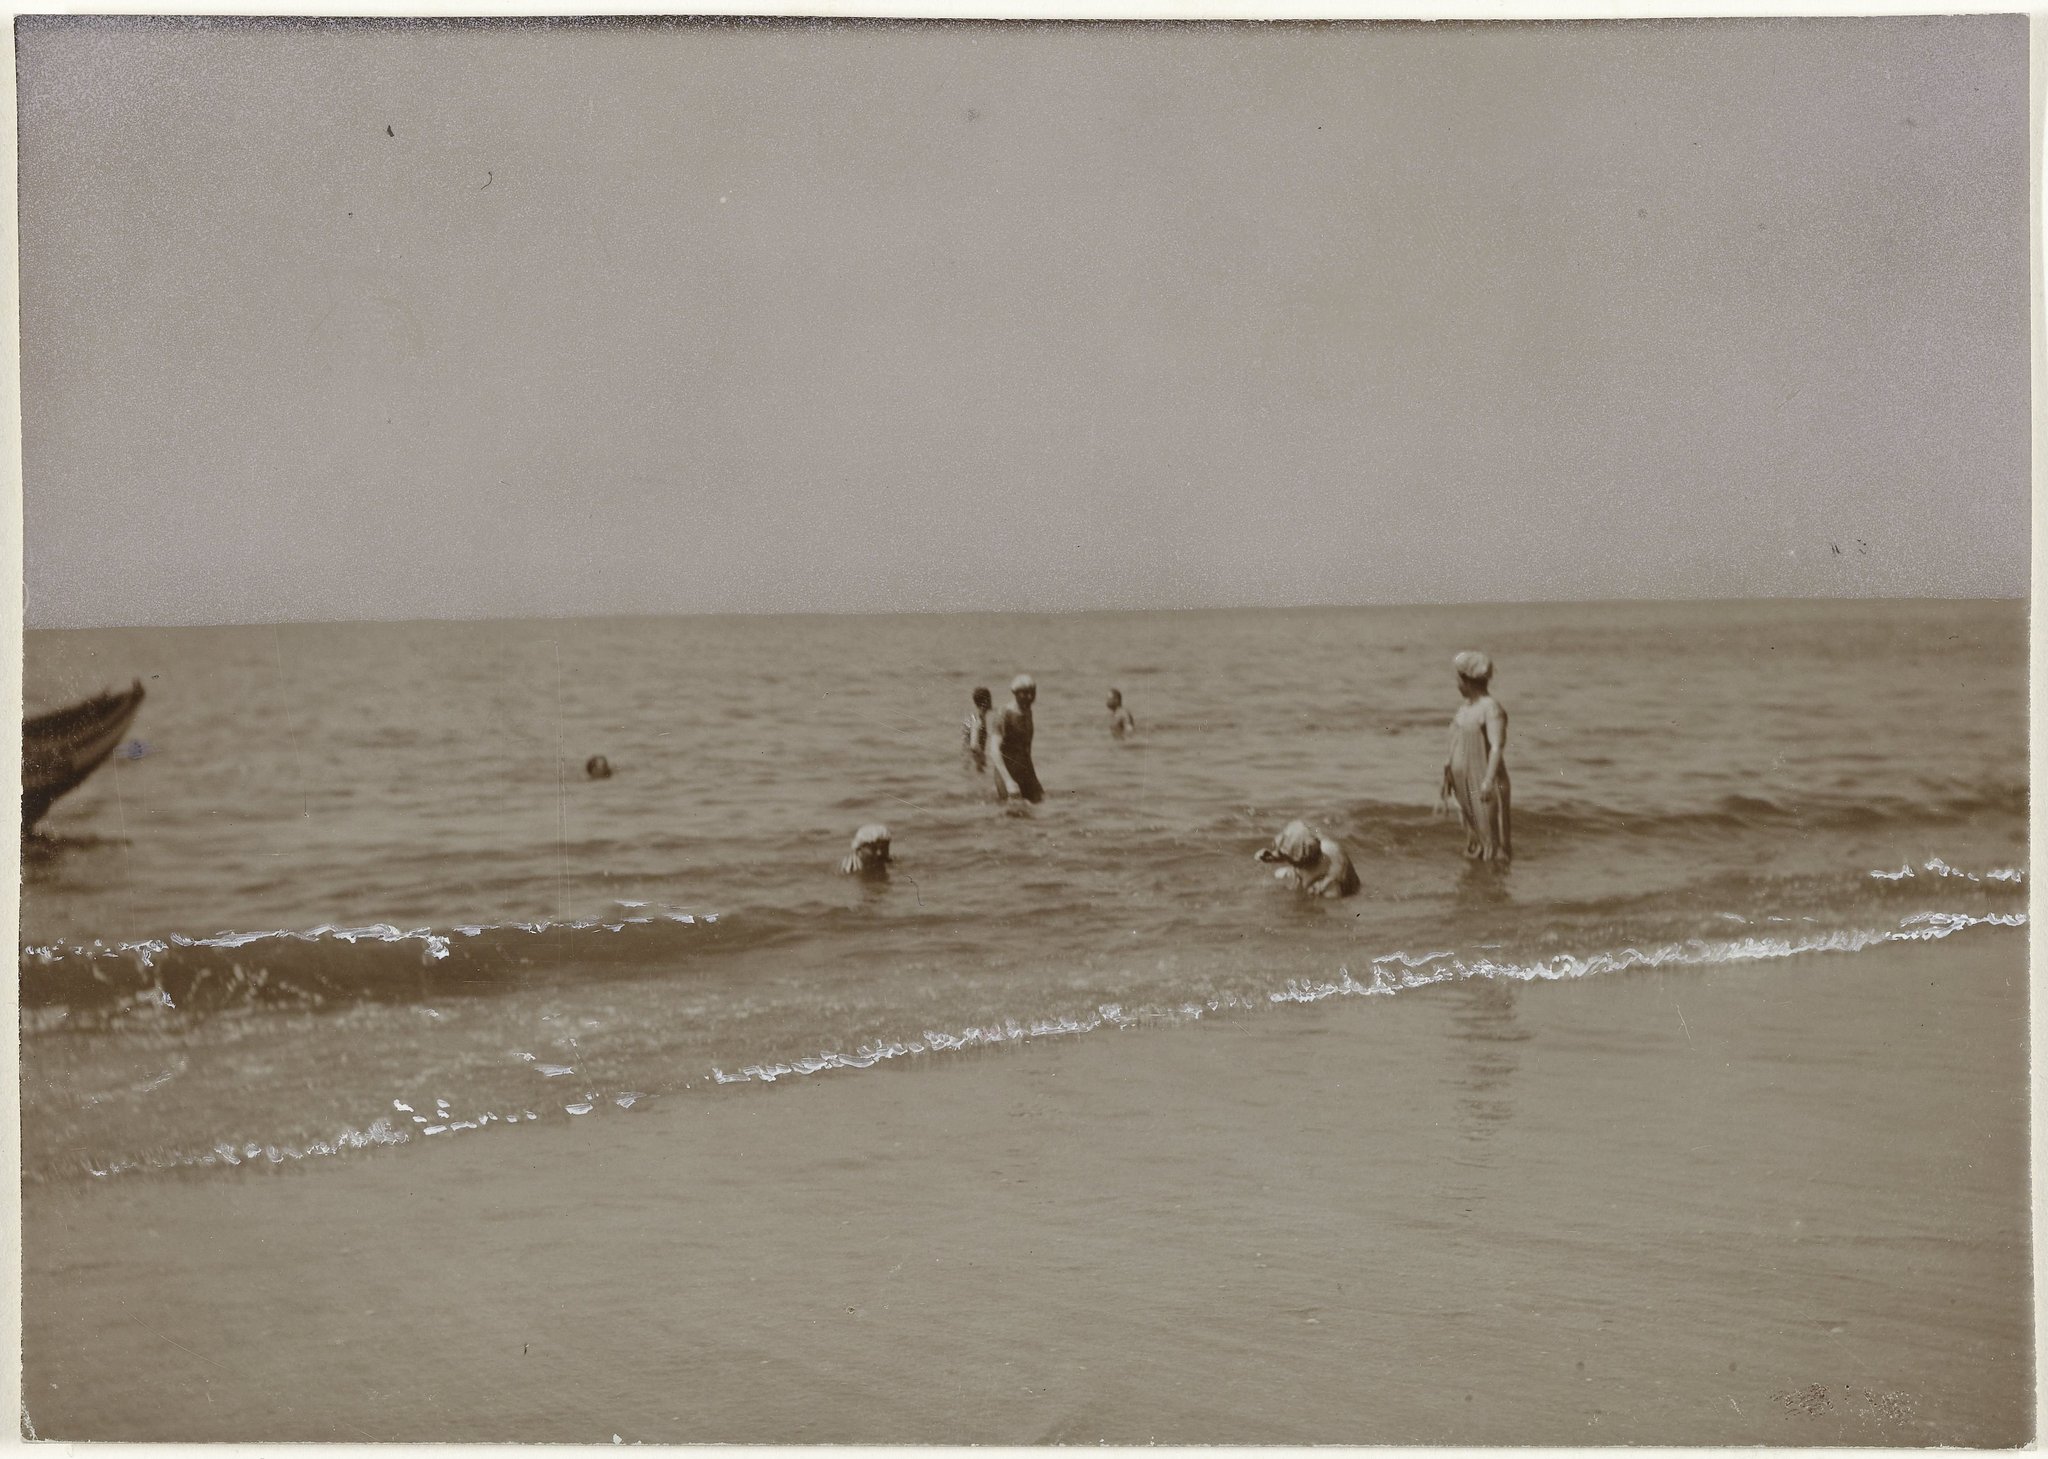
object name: photograph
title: Spelen in zee in Zandvoort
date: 1900-1905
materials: photographic support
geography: zandvoort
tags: beach (as place of recreation)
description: Een aantal mensen in lange badpakken en badmutsen op spelen en zwemmen in zee.